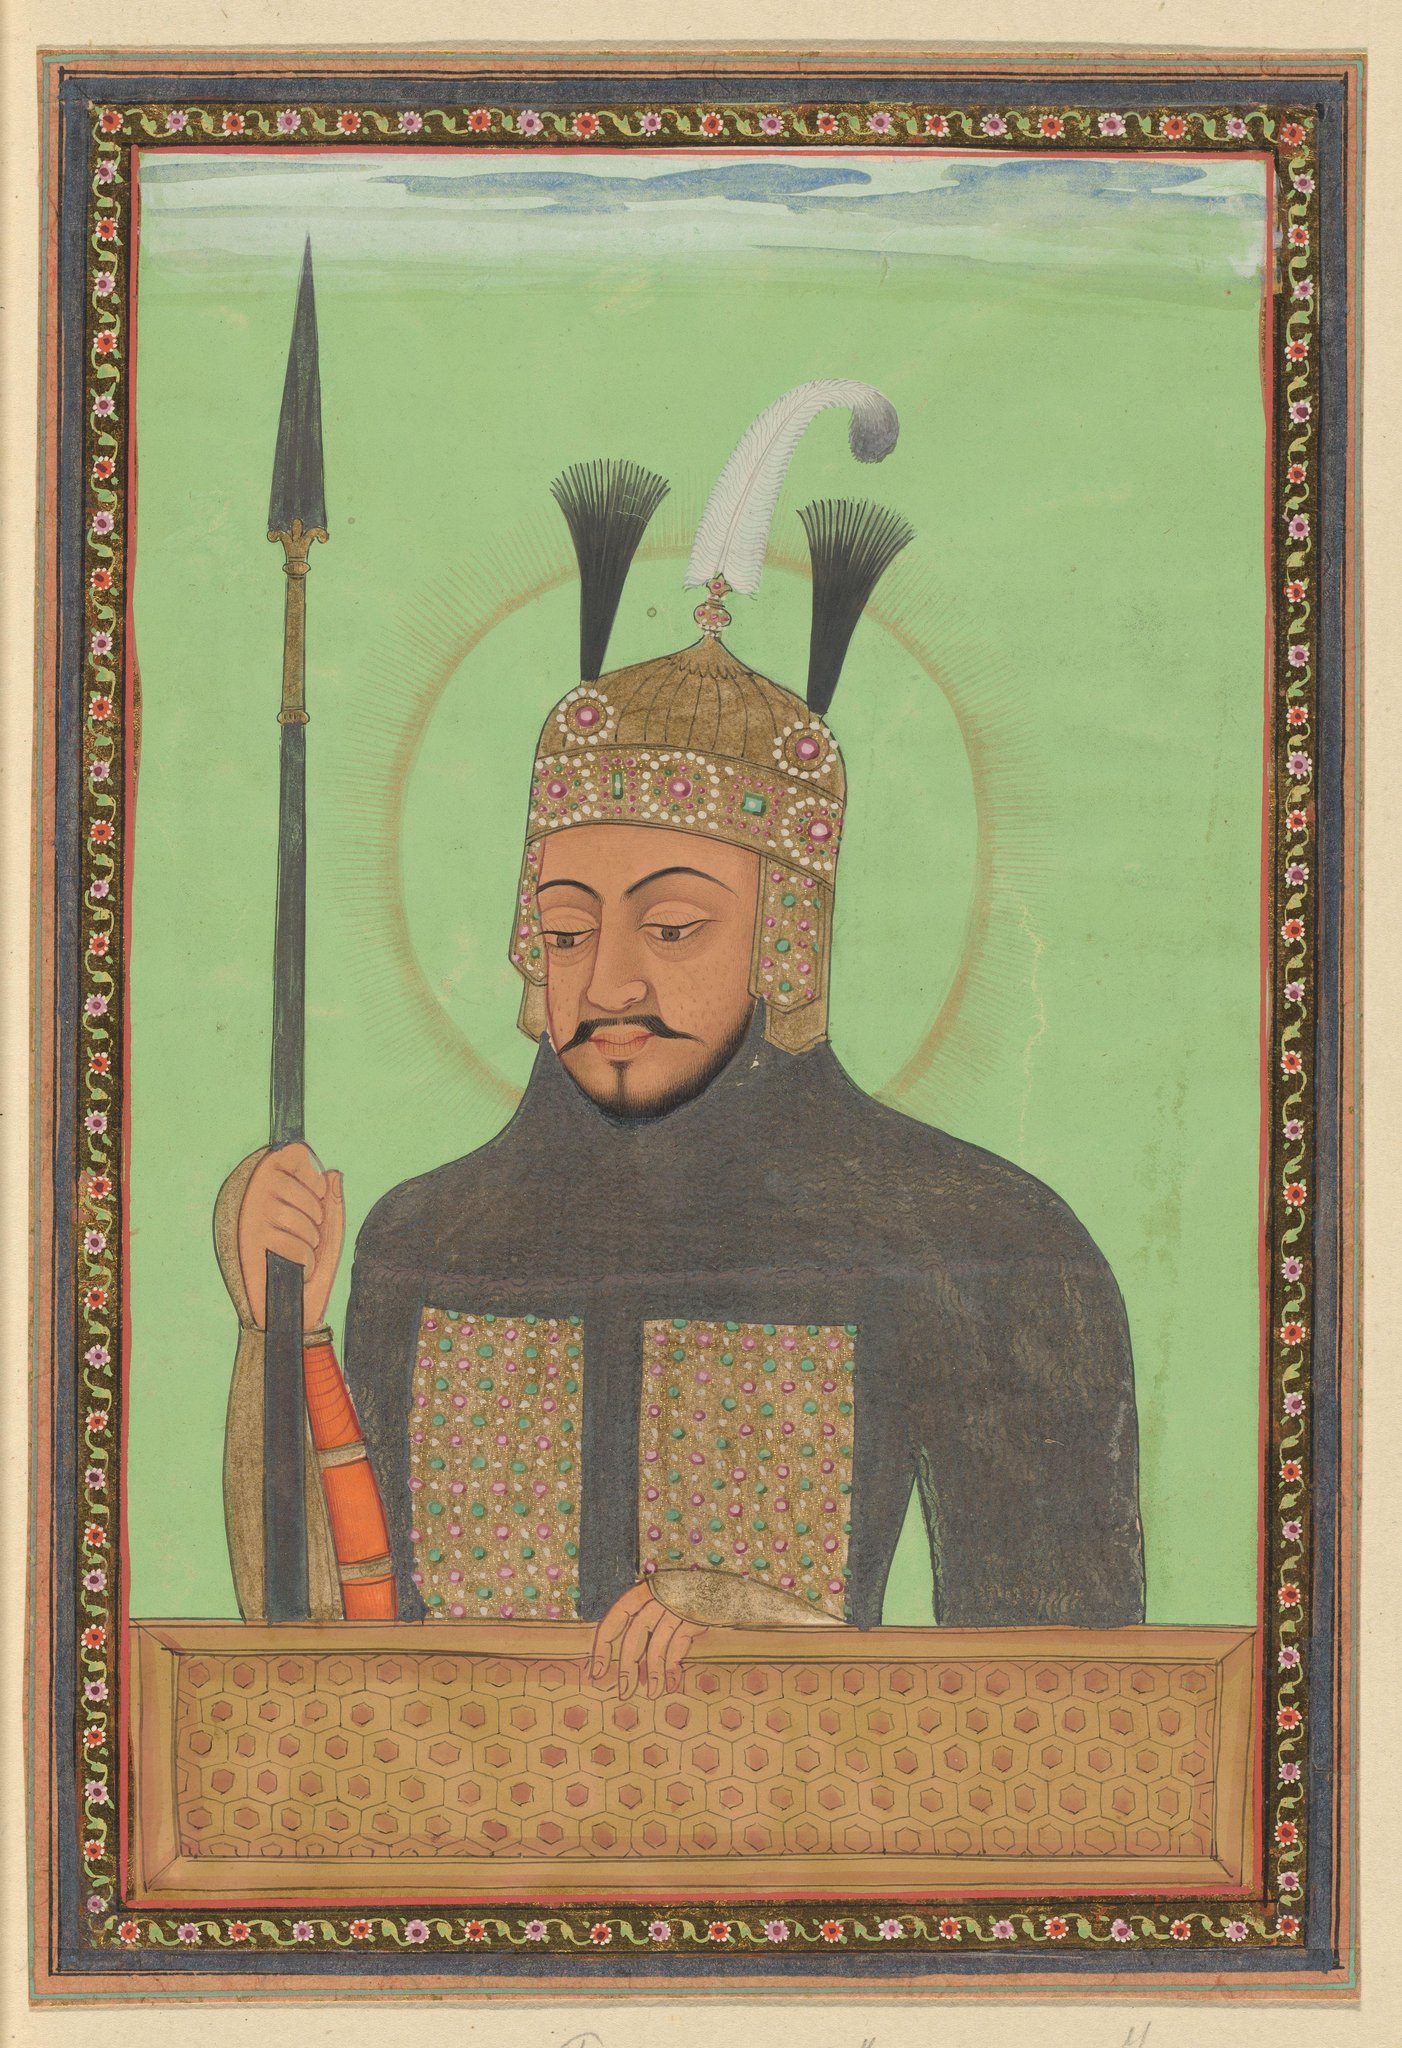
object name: indian miniature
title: Portret van Timur, ook wel genoemd Tamerlan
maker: Anonymous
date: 1686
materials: paint, gold leaf, gouache, paper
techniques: brush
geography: golkonda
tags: amsterdam, print maker, mayor, nicolaes cornelisz. witsen, historical person (...) - historical person (...) portrayed alone, ruler, sovereign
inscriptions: collector's mark: Lugt 240, annotation: ‘Baber, Zoon van Tamerlan, Koning van Indostan ook genoemd Sultan Abulkasim Baber’, collector's mark: Lugt 1838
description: Tamerlan (1336-1405) is tot aan zijn middel afgebeeld, half naar links gewend, met een helm op zijn hoofd, een lans in zijn rechter hand en zijn linker hand rust op de balustrade. Blad 1A in het `Witsen-Album', met 49 Indiase miniaturen van vorsten. Boven het portret een stukje papier met de naam in het Perzisch. Onder het portret een stukje papier met de naam in het Portugees.